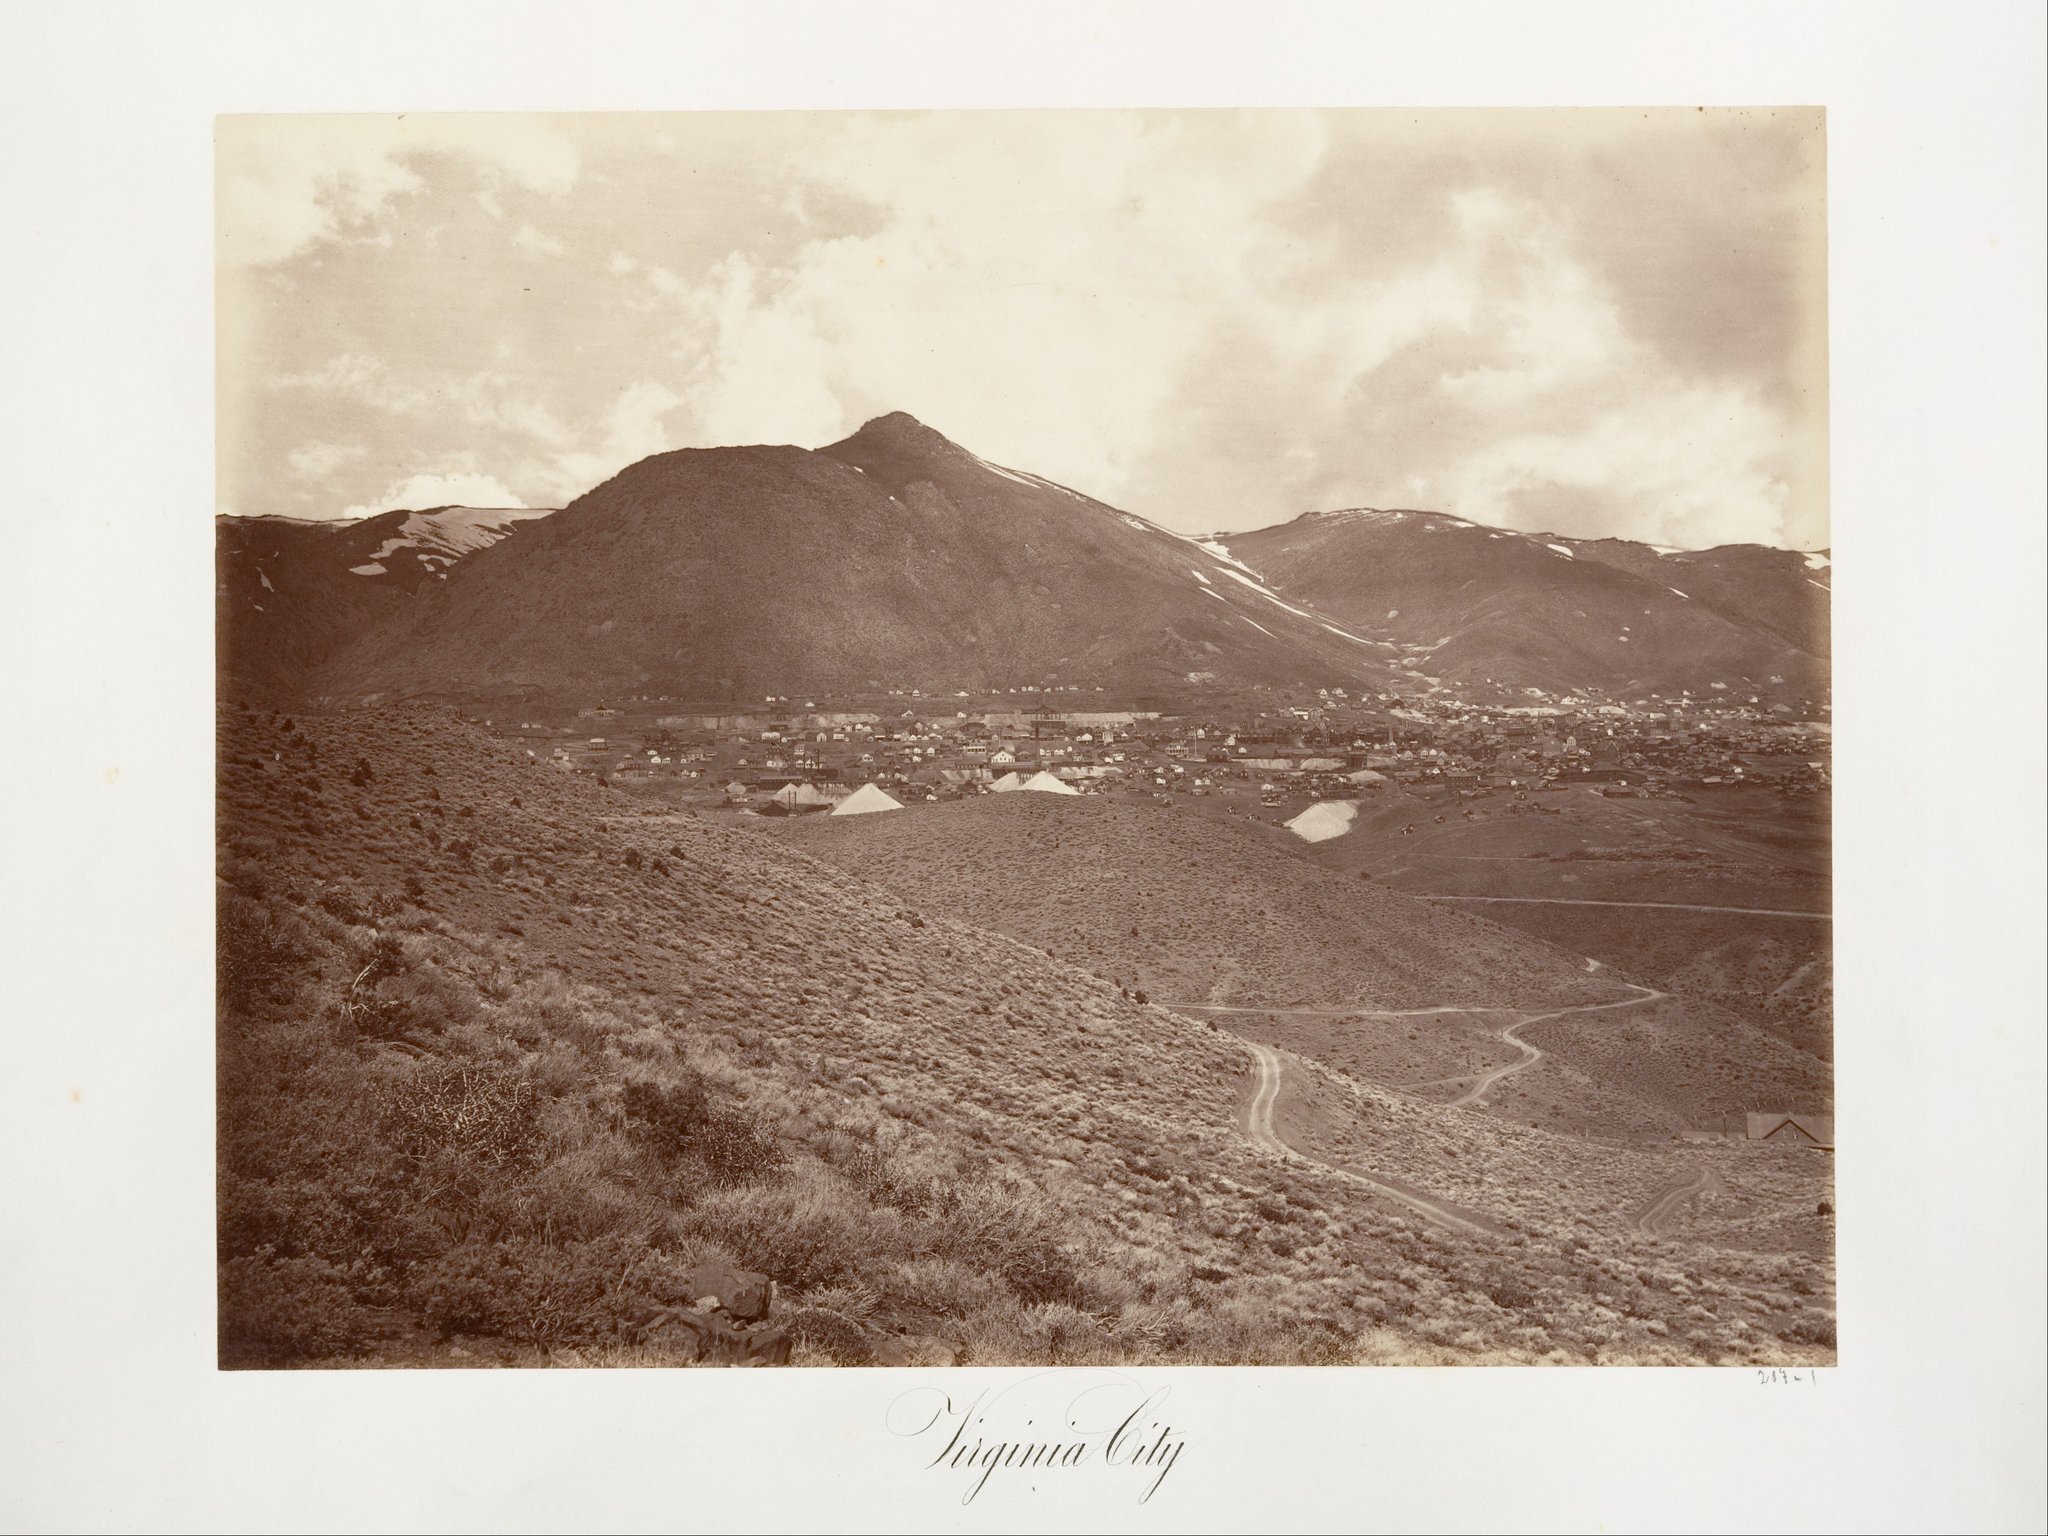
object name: photograph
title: Virginia City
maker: carleton e. watkins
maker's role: artist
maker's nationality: american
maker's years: 1829-1916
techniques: albumen silver print, glass negative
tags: hills,landscapes